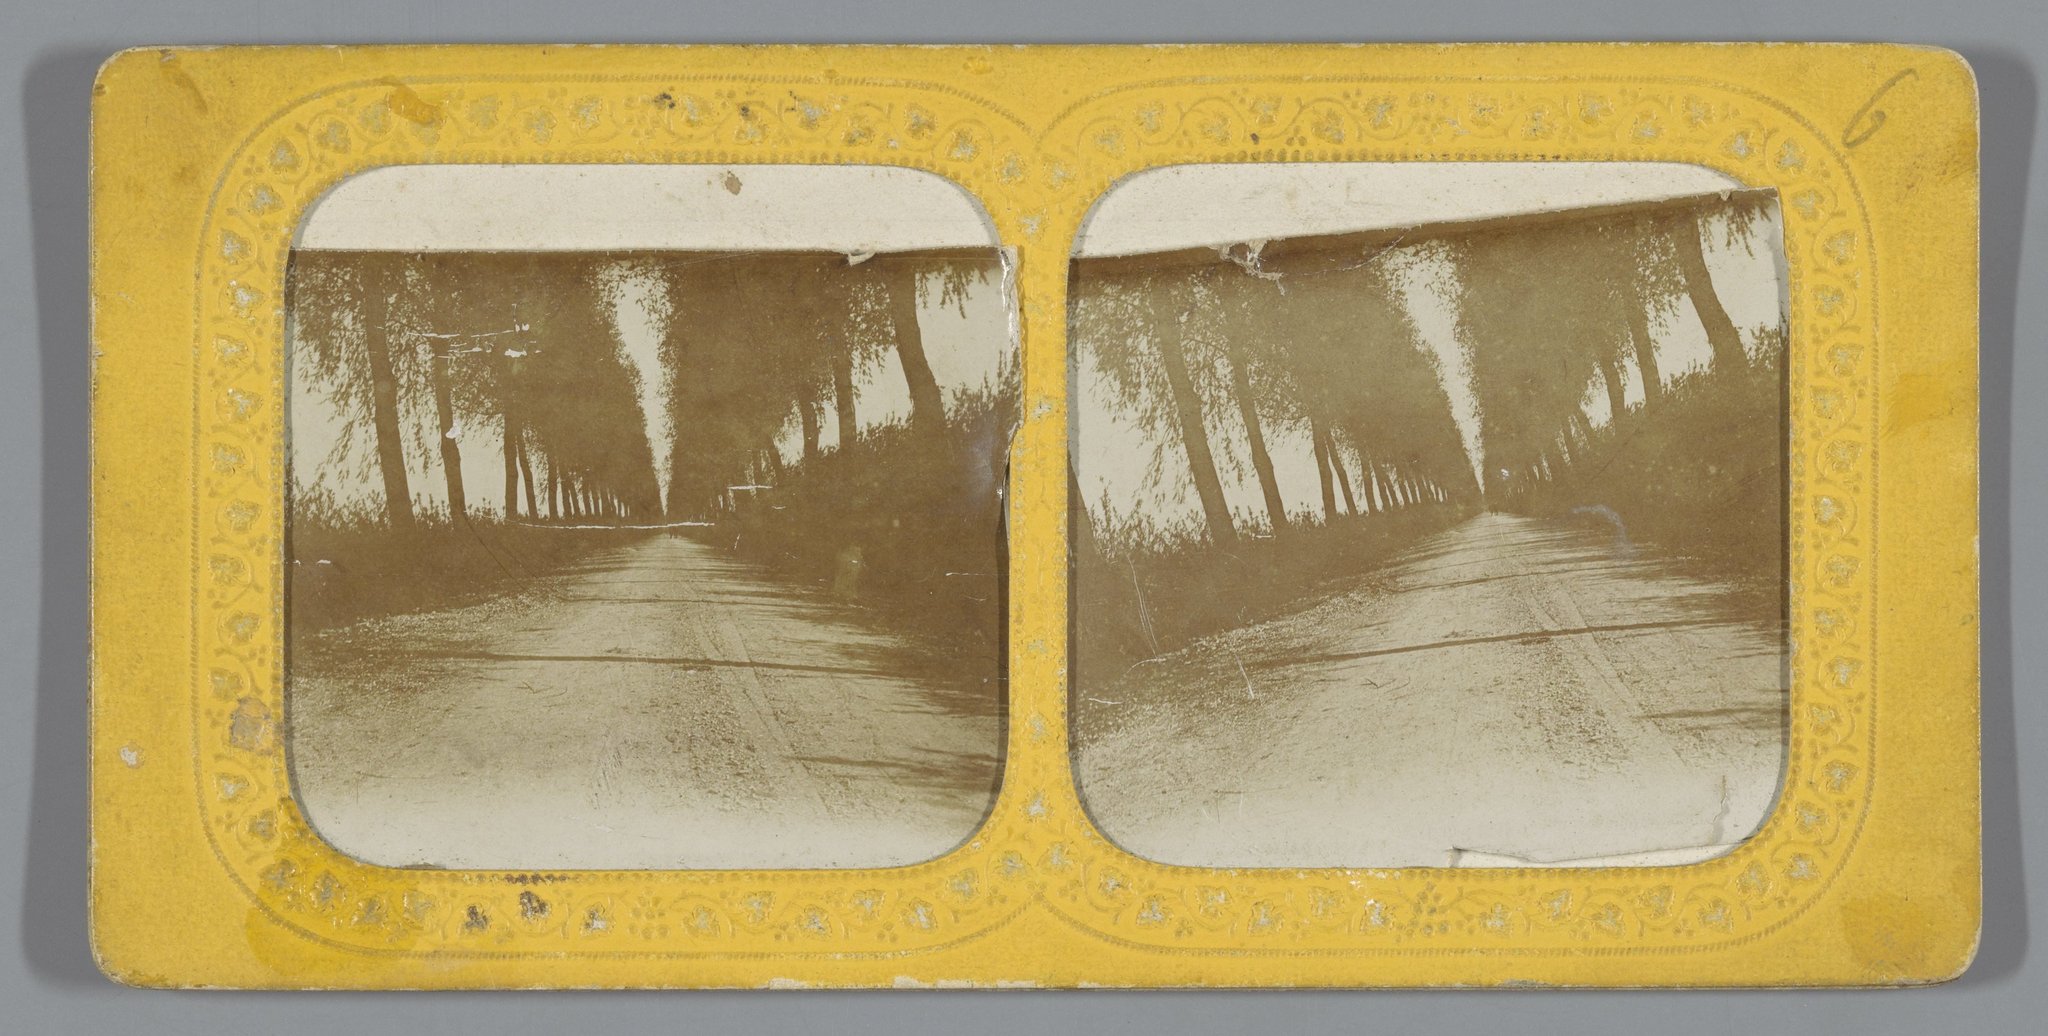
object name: stereograph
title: Pettelaarseweg nabij Den Bosch, Nederland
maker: Anonymous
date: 1855-1875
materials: cardboard, paper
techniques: albumen print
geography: den bosch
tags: public road, den bosch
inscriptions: inscription: ‘Groep v/d opera/ Groupe de l'Opéra’, number: ‘6’